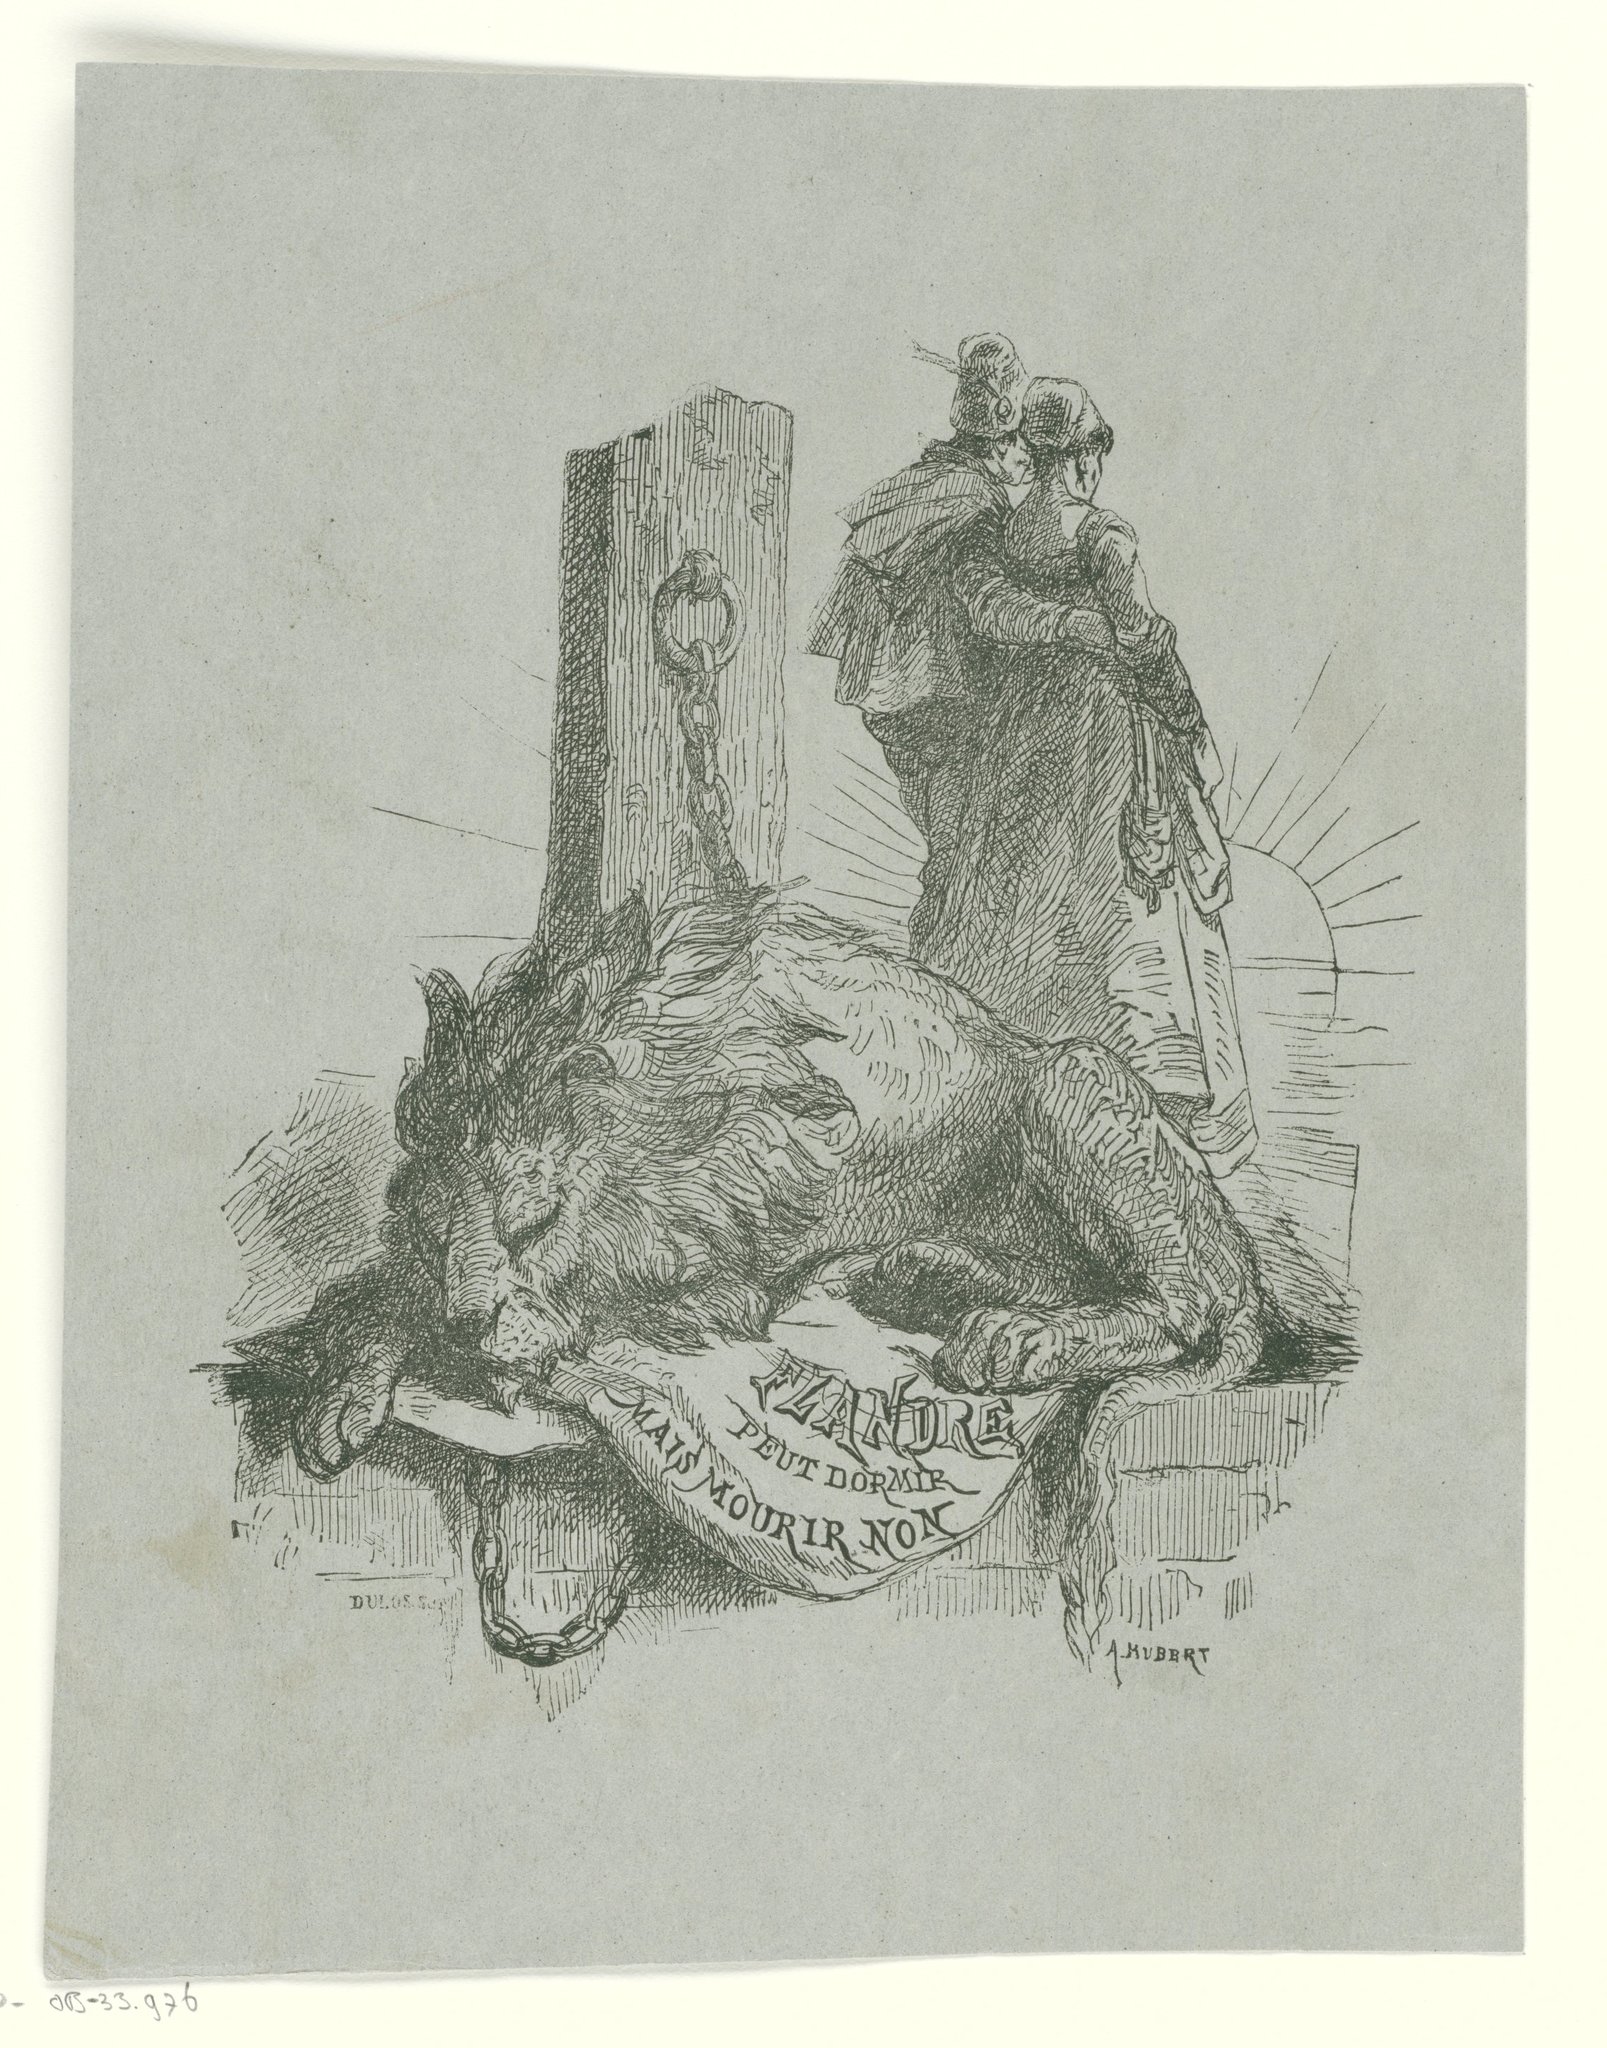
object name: book illustration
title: Flandre peut dormir mais mourir non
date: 1869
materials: paper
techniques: engraving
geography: paris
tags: eulenspiegel, sunset, beasts of prey, predatory animals: lion, couple of lovers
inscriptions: collector's mark: Lugt 2228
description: Prent uit: Charles de Coster. La légende et les aventures héroiques, joyeuses et glorieuses d'Ulenspiegel et de Lamme Goedzak au pays de Flandres et ailleurs. Parijs: Librairie internationale; Brussel: A. Lacroix, Verboeckhoven & Cie, 1869.